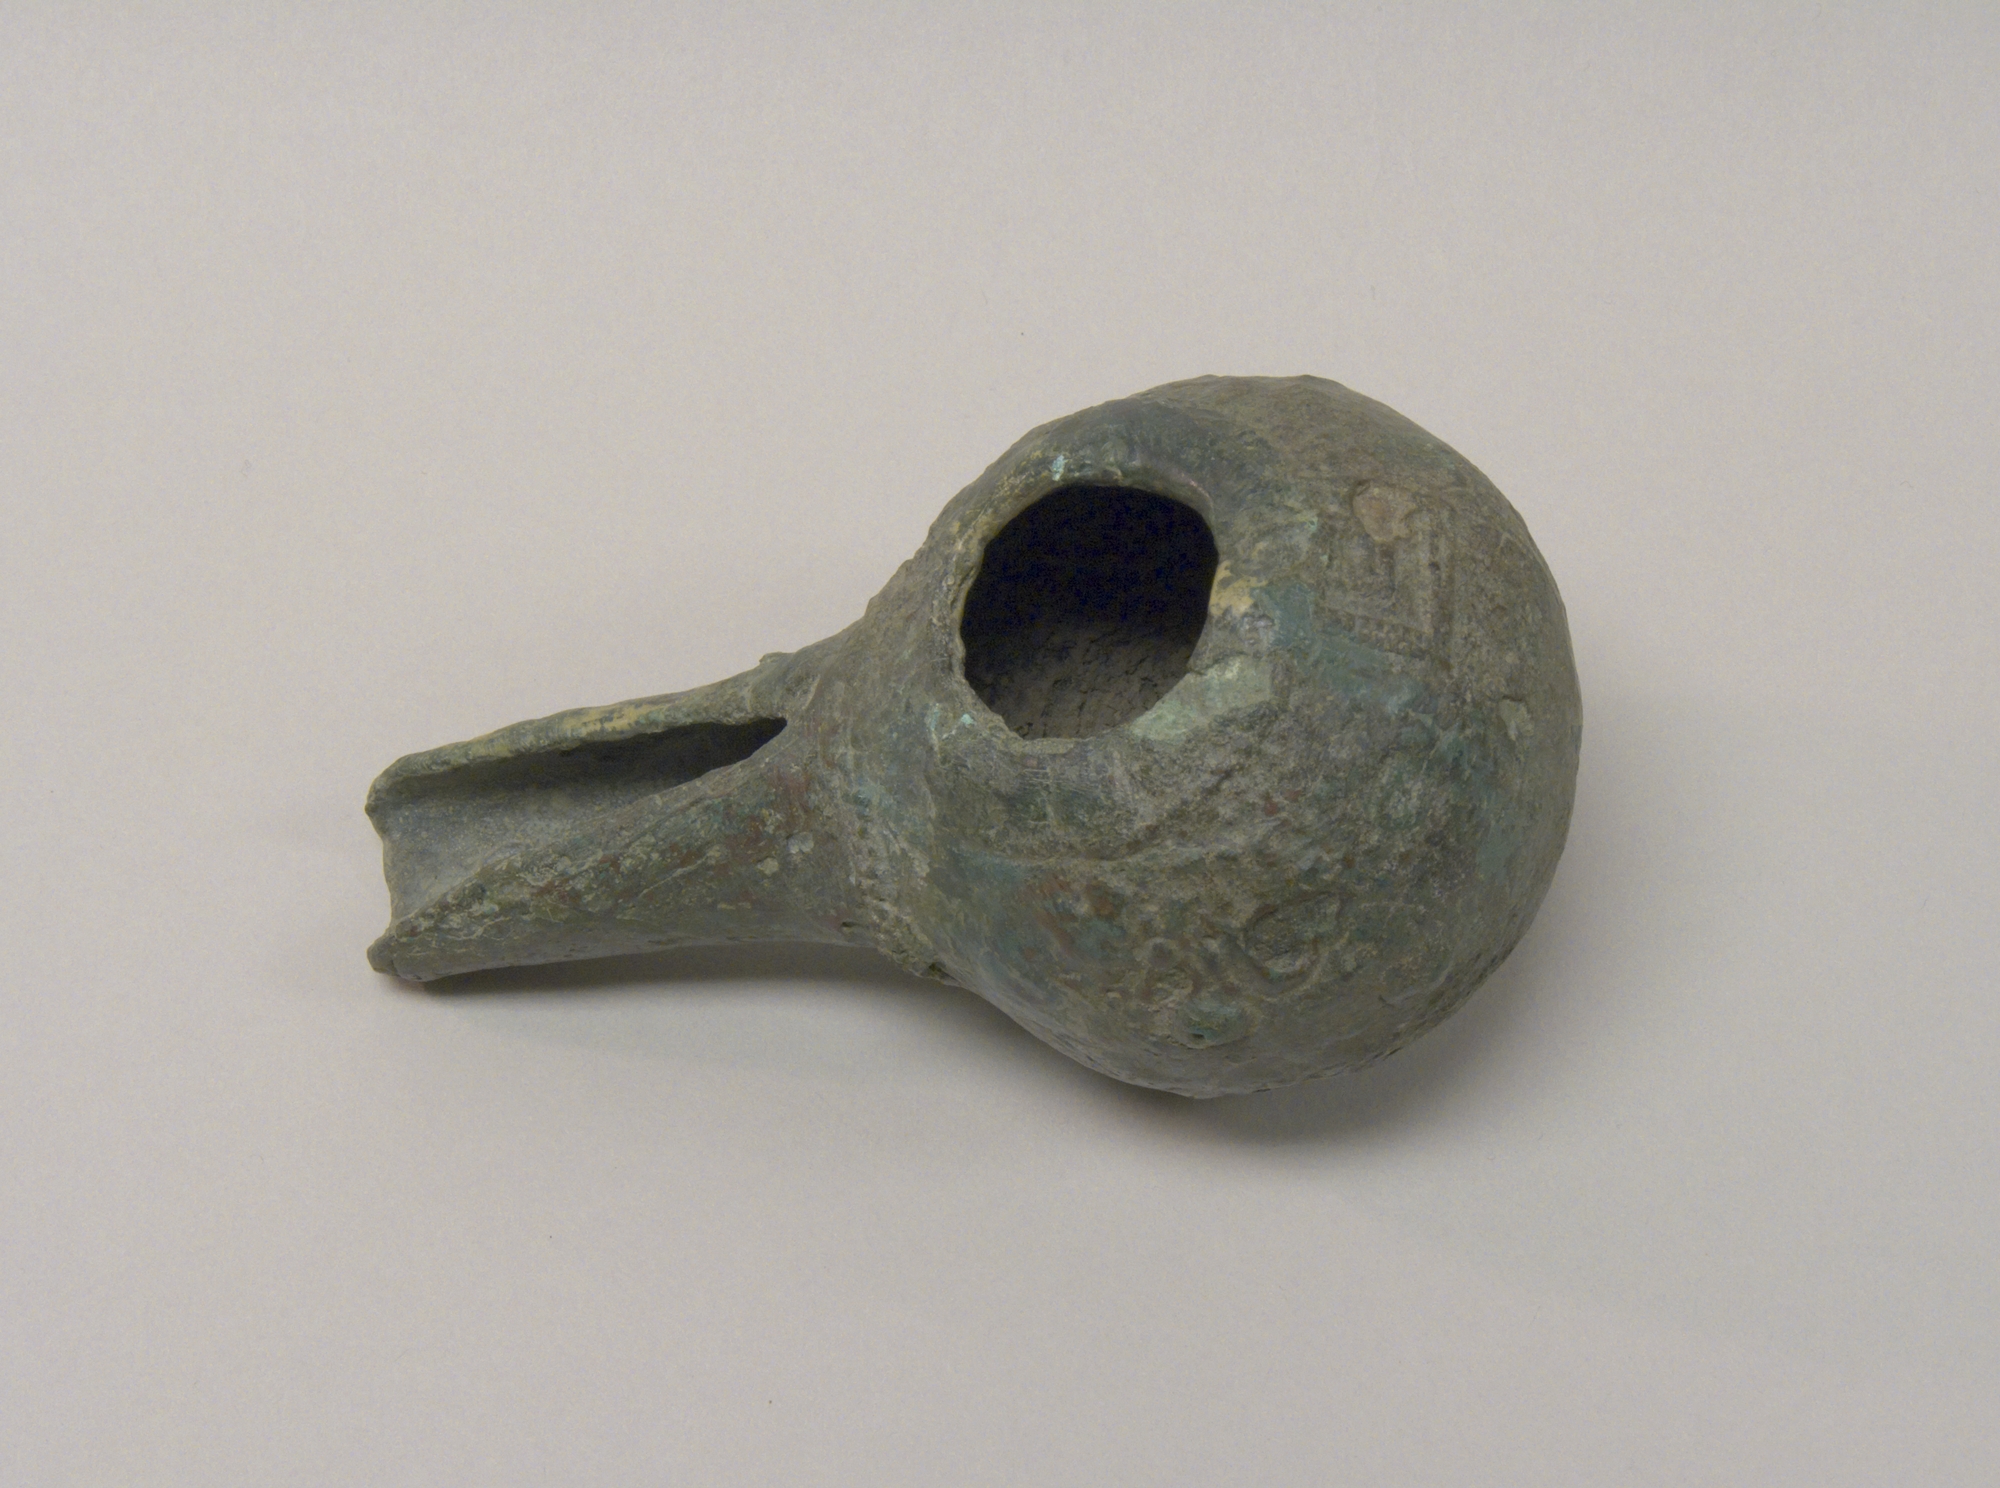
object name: dipper fragment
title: Fragment of a Dipper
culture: vietnamese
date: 500 BCE-300 CE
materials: bronze